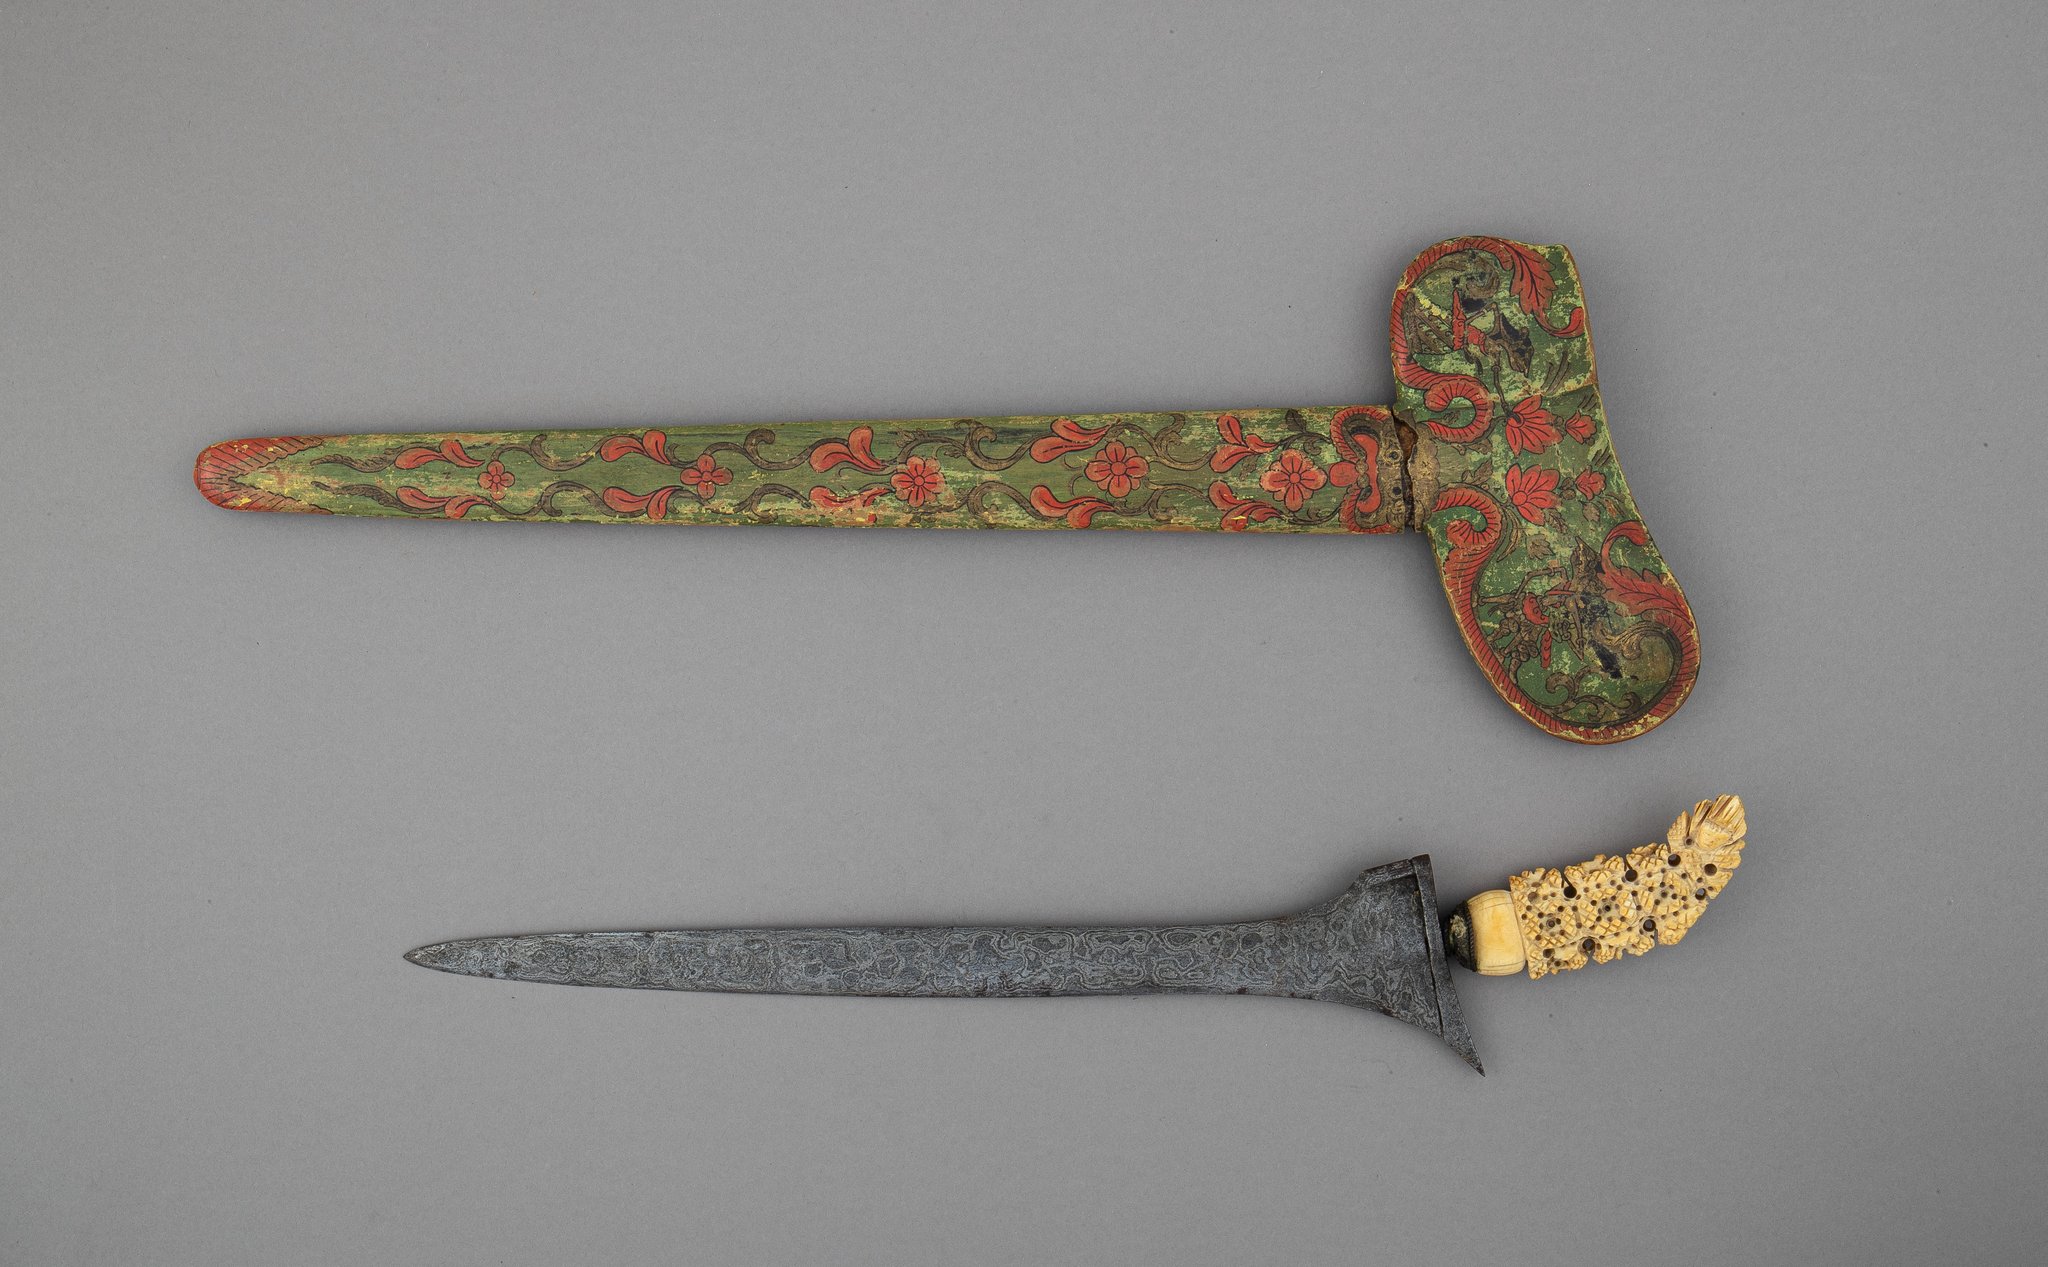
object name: kris with sheath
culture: madurese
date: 1501-1900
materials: brass, ivory, steel, wood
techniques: polychromy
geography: indonesia